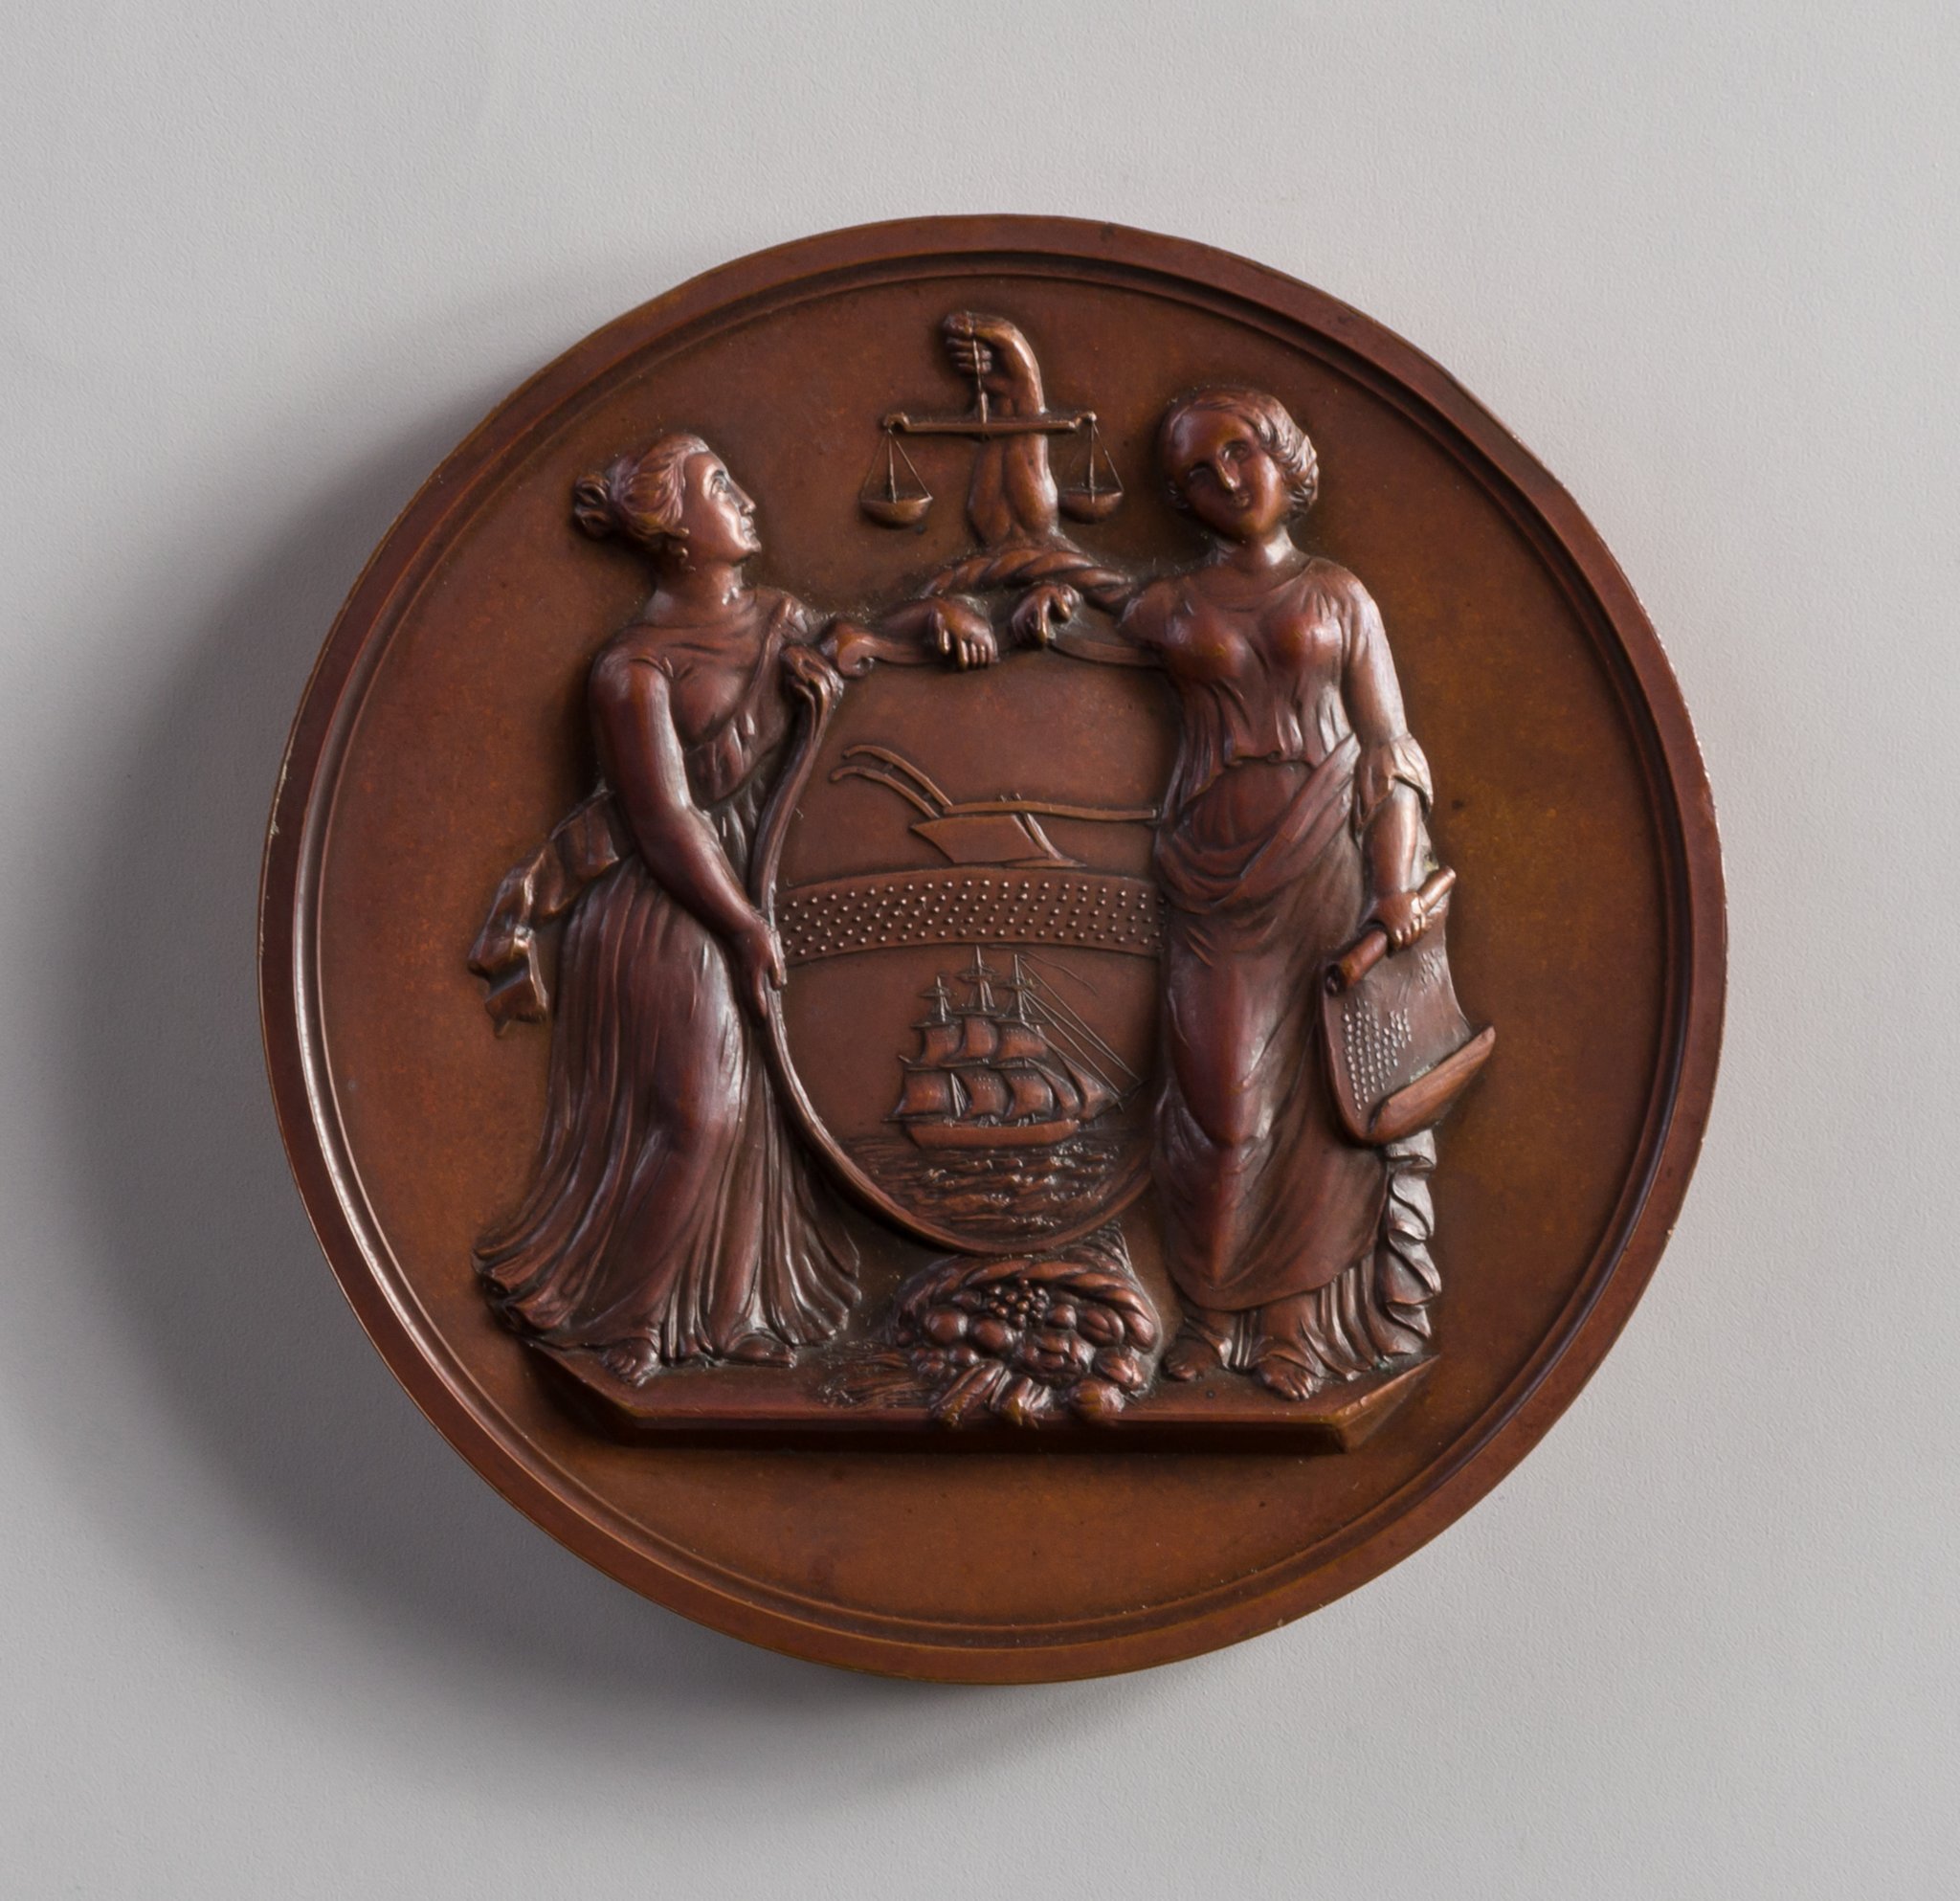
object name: medal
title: Medal Awarded to Captains Low, Crighton, and Stougger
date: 1854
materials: bronze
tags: women,ships